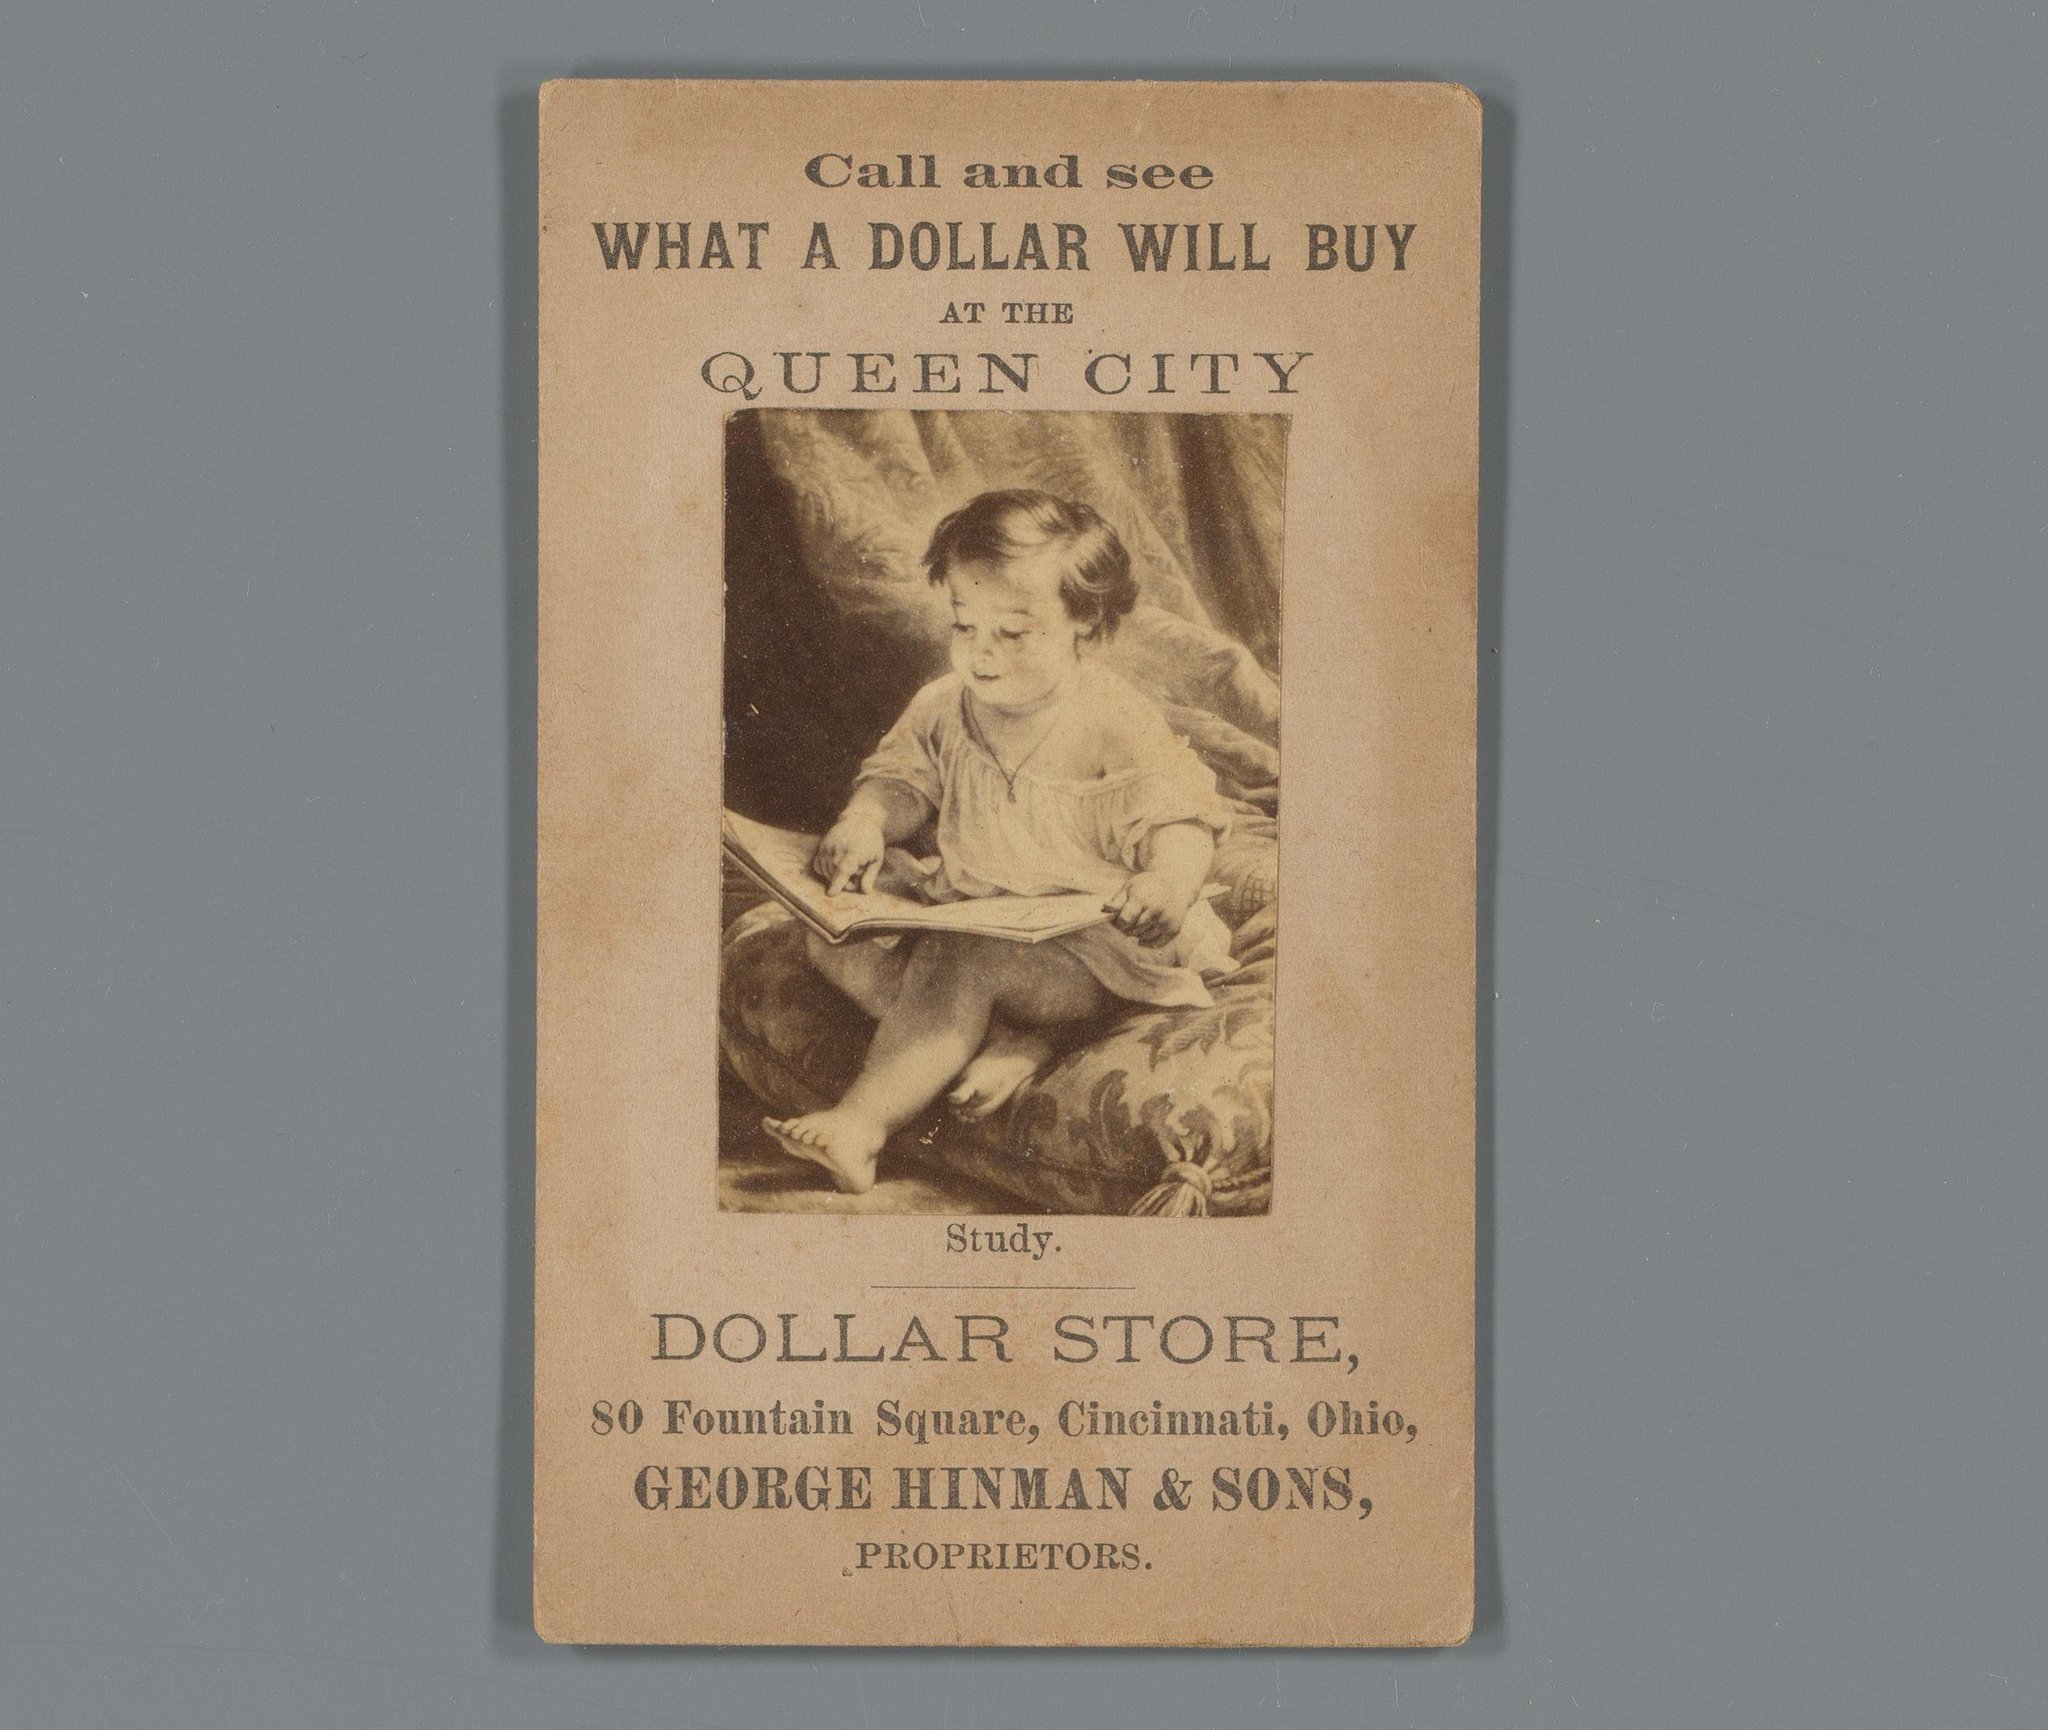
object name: reproduction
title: Reclame voor de Dollar Store van George Hinman & Sons in Cincinatti, Ohio, met fotoreproductie van een schildering van een lezende peuter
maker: Anonymous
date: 1850-1915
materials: cardboard, photographic support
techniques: albumen print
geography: united states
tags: toddler, reading, advertising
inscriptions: inscription: ‘(...)’